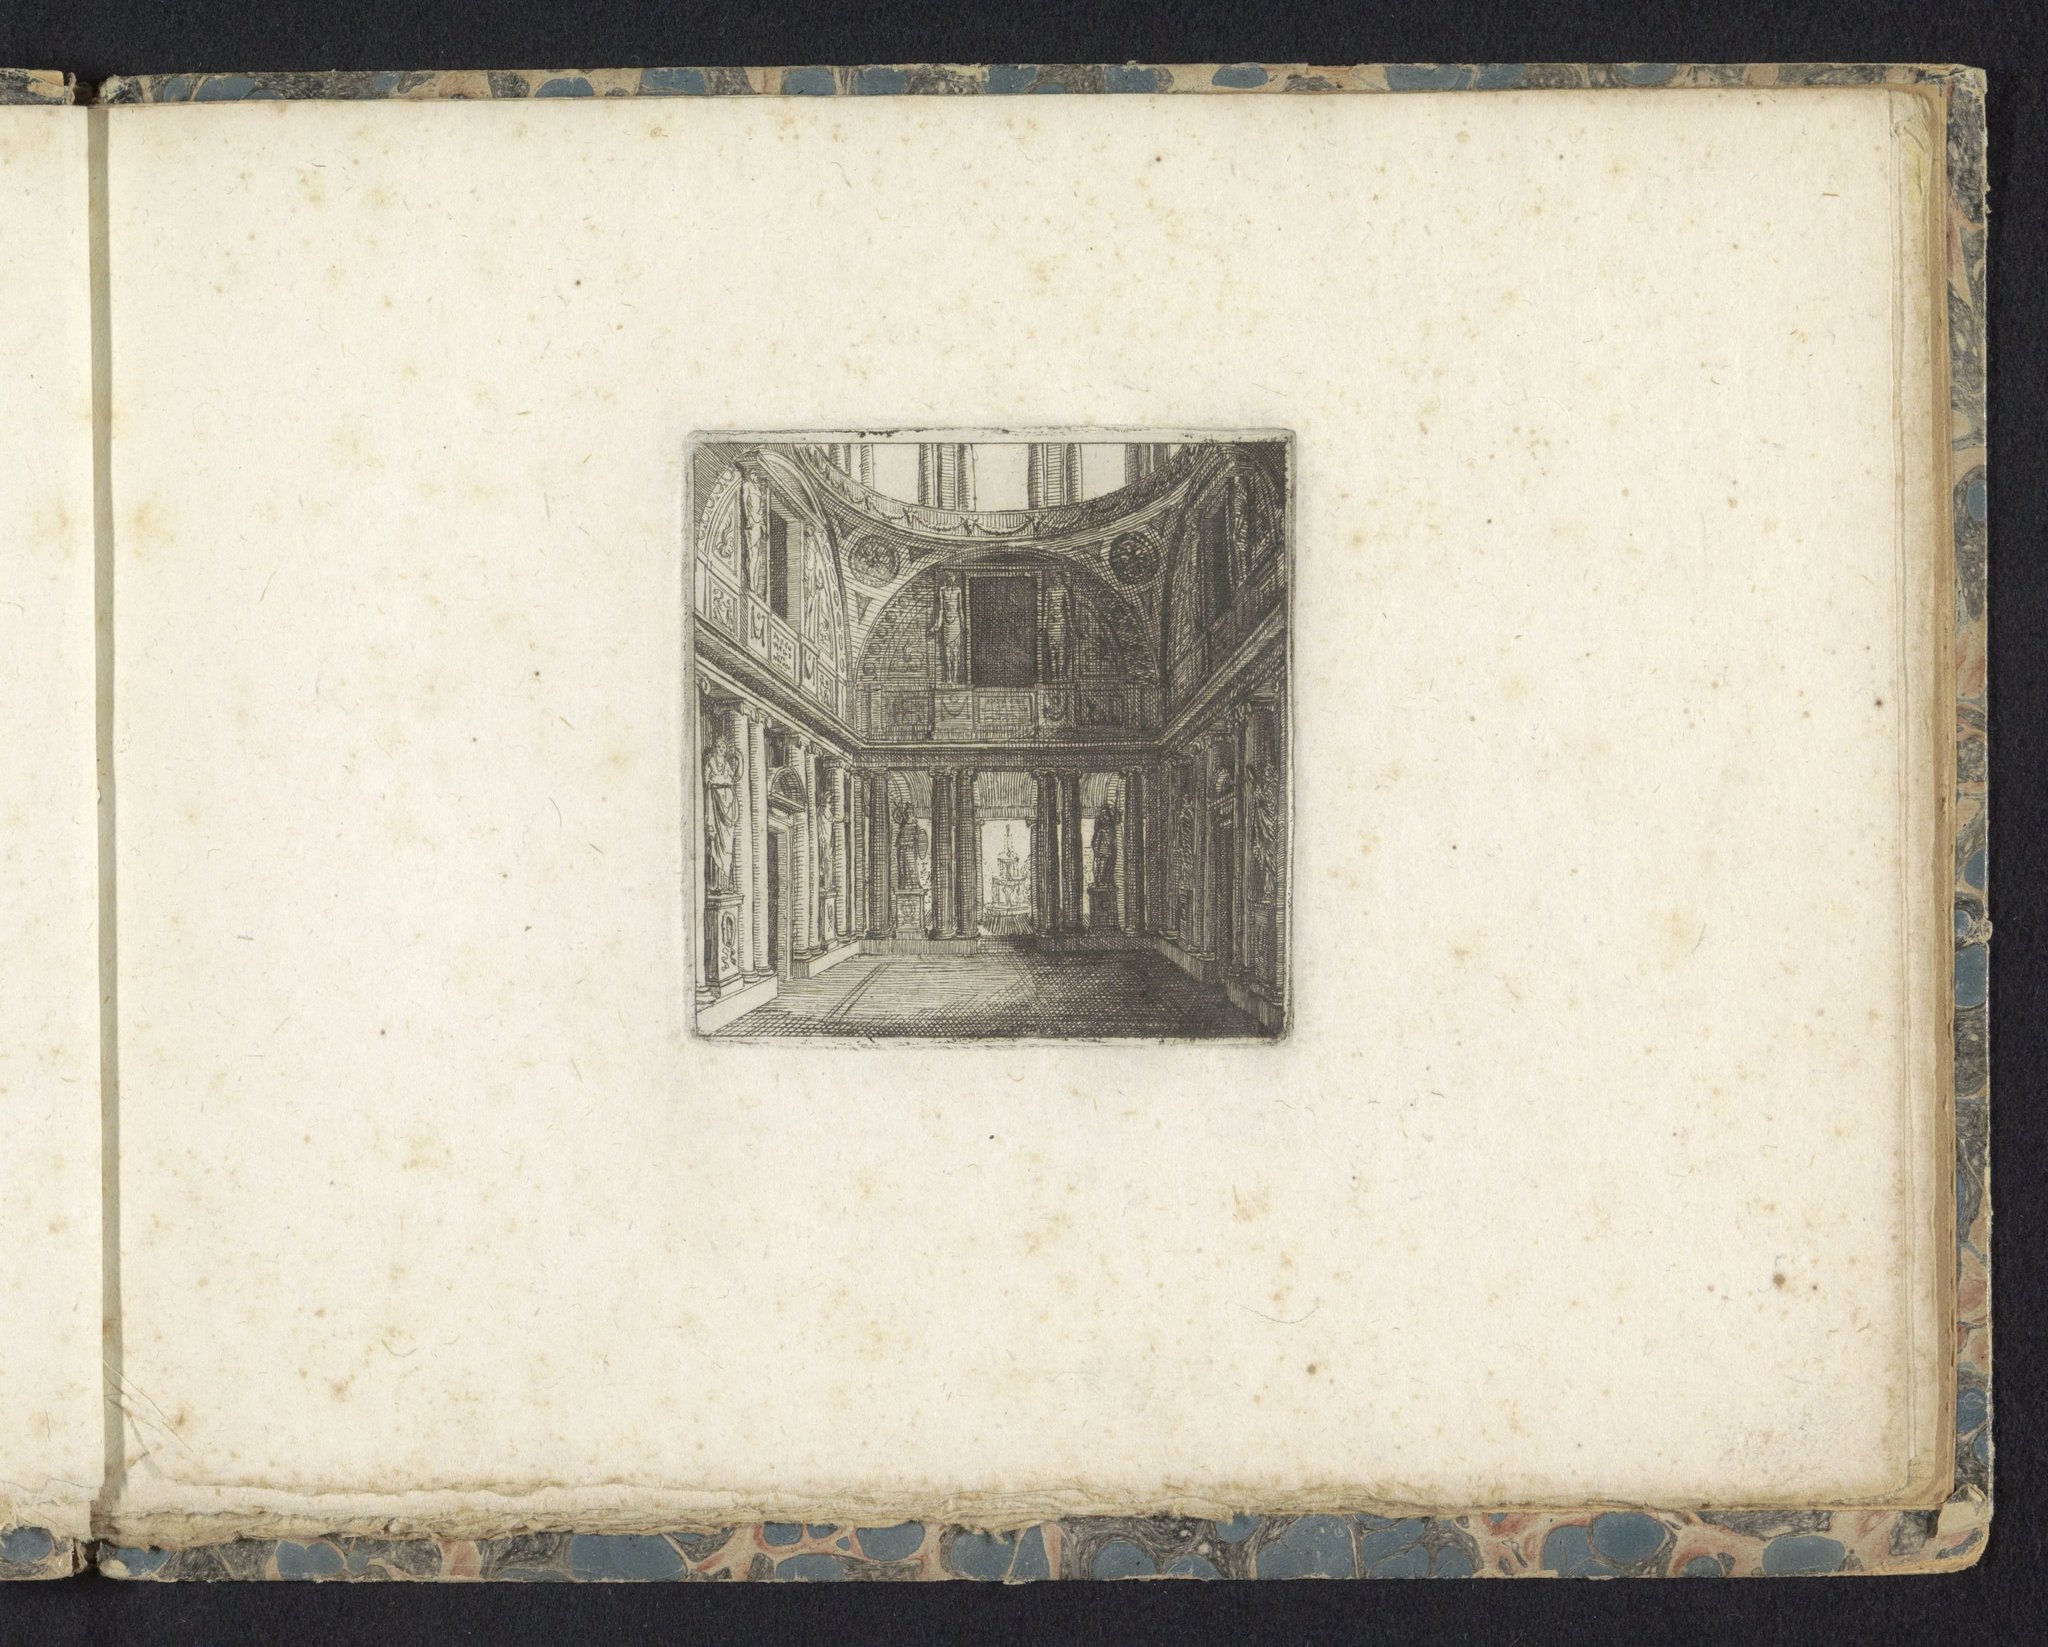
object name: album leaf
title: Decorontwerp met het interieur van een tempel met een koepel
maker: Anonymous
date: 1750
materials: paper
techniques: etching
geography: italy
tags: set, scenery ~ stage, temple, shrine ~ roman religion, interior ~ representation of a building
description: Deze prent maakt deel uit van een reeks van ten minste dertien prenten met decorontwerpen.